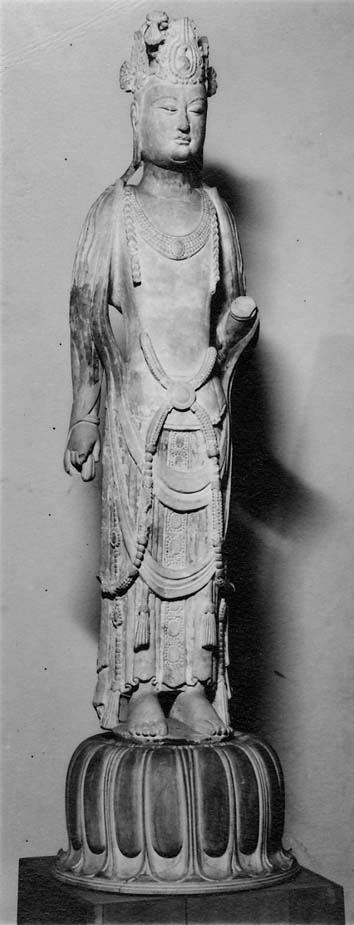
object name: figure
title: Bodhisattva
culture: chinese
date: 581-618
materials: stone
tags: buddhism,bodhisattvas